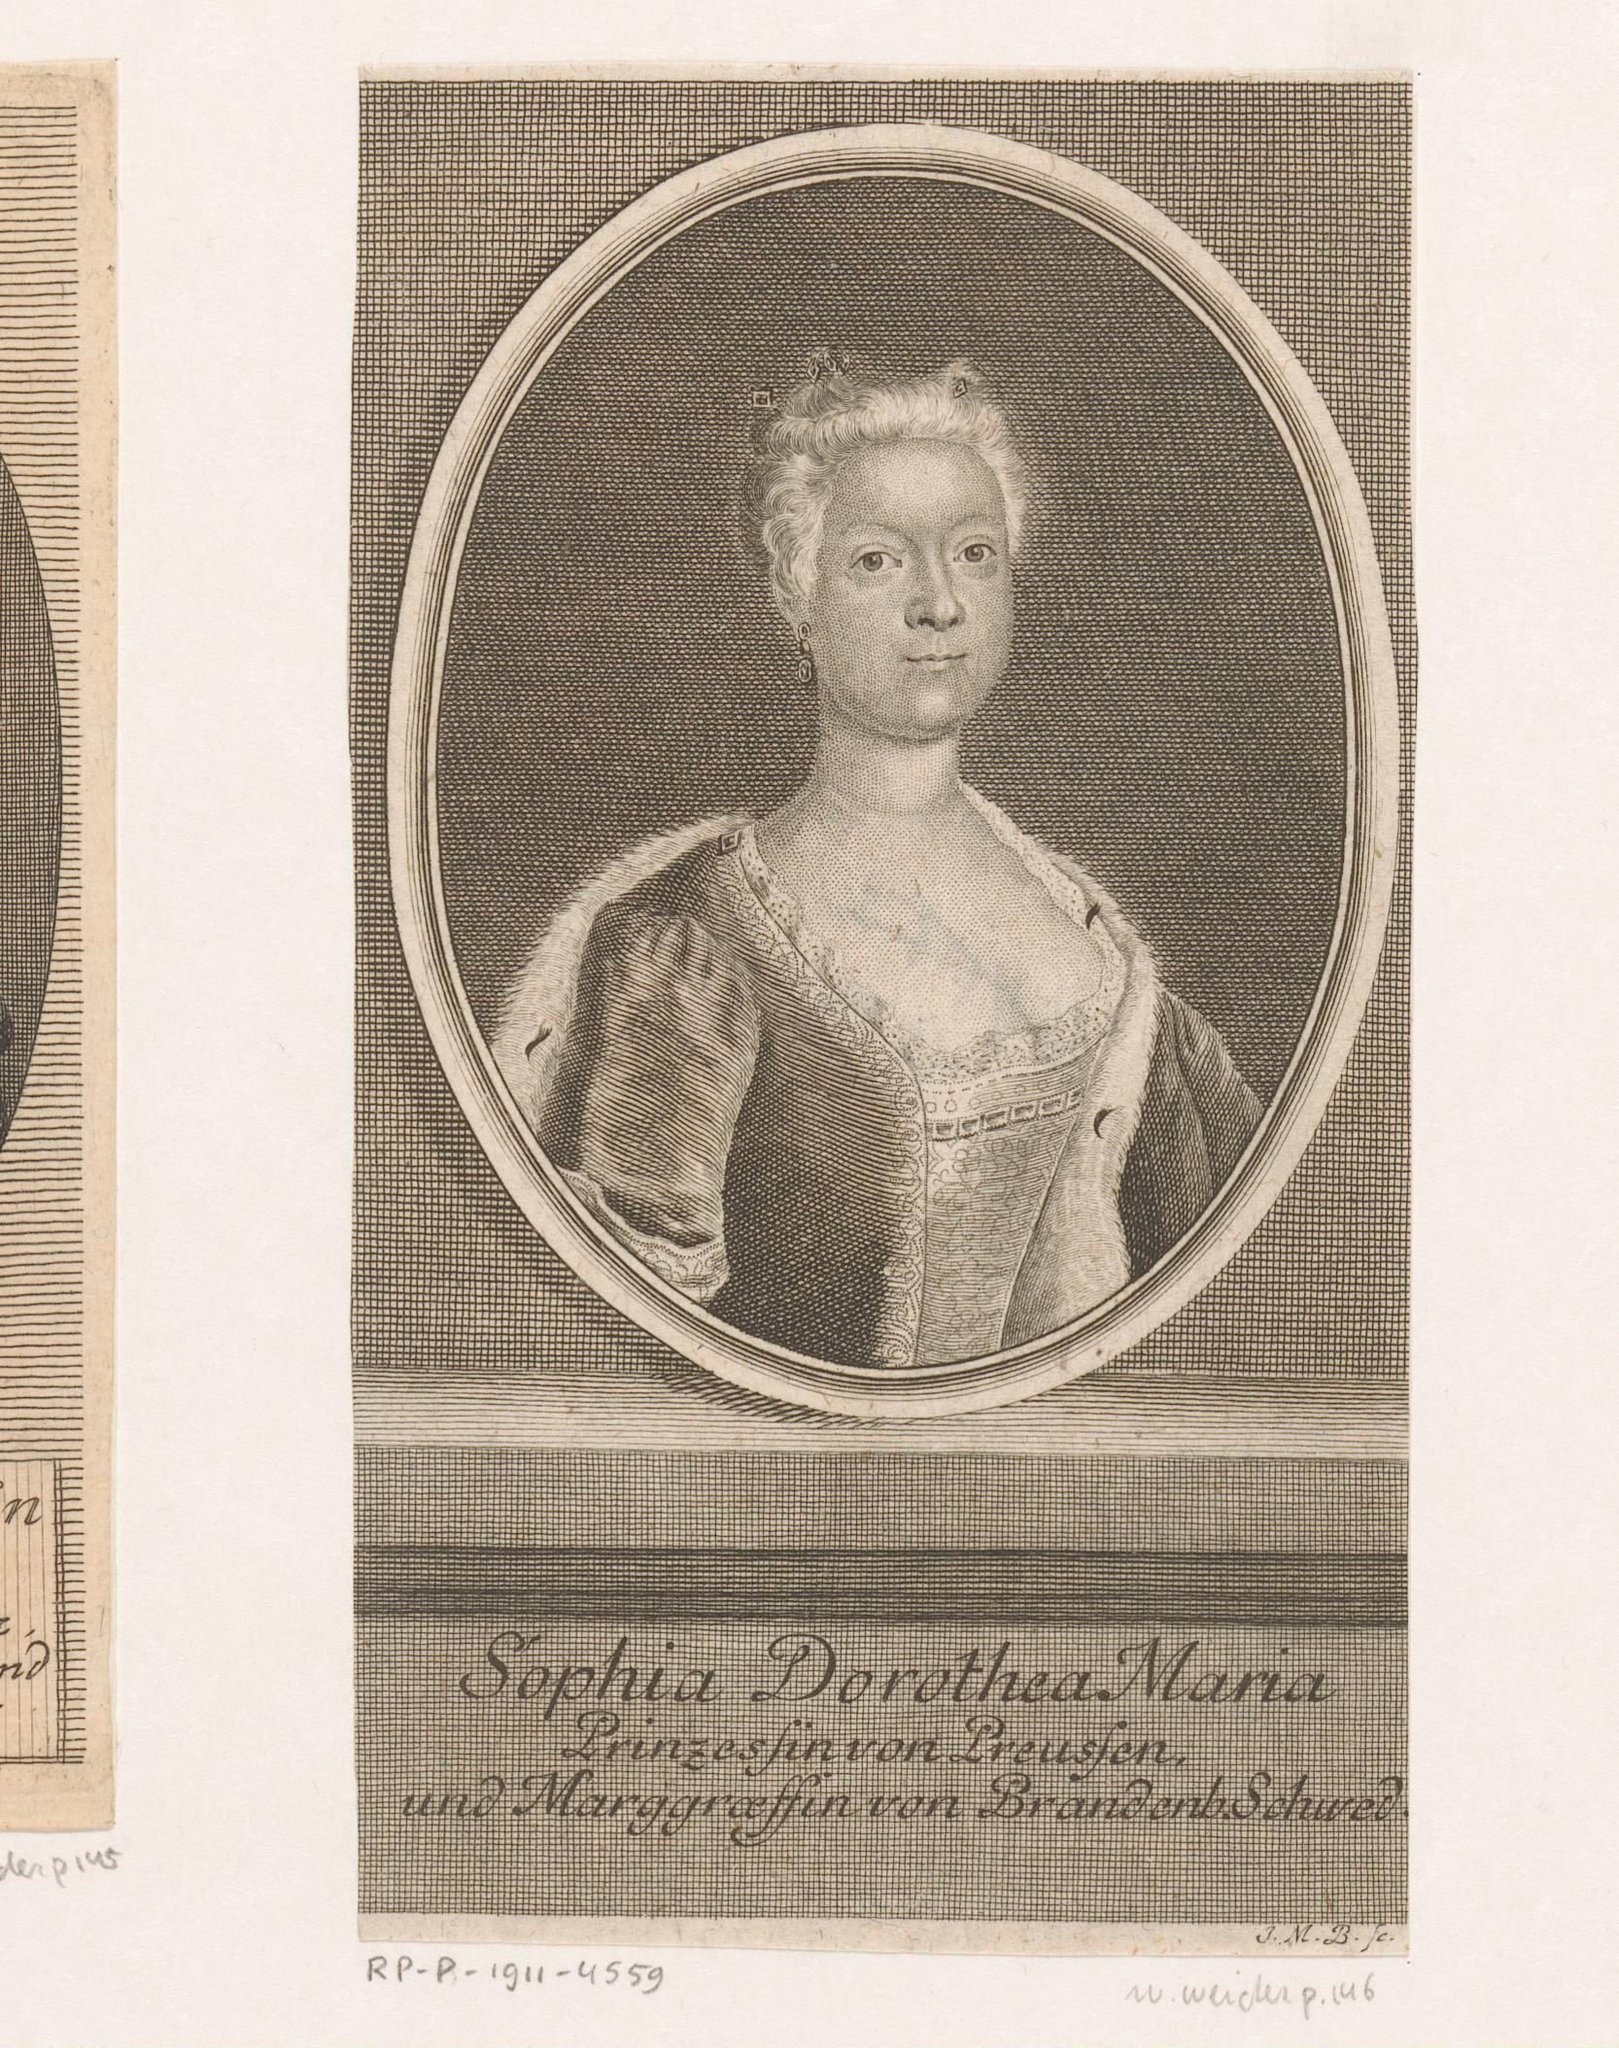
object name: print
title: Portret van Sophia Dorothea, koningin van Pruisen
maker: johann martin bernigeroth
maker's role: print maker, publisher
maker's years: 1713-1767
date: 1734-1767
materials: paper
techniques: engraving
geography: leipzig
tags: berlin, historical persons - bb - woman, mantle, gown, dress (symbol of sovereignty)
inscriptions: collector's mark: Lugt 2228